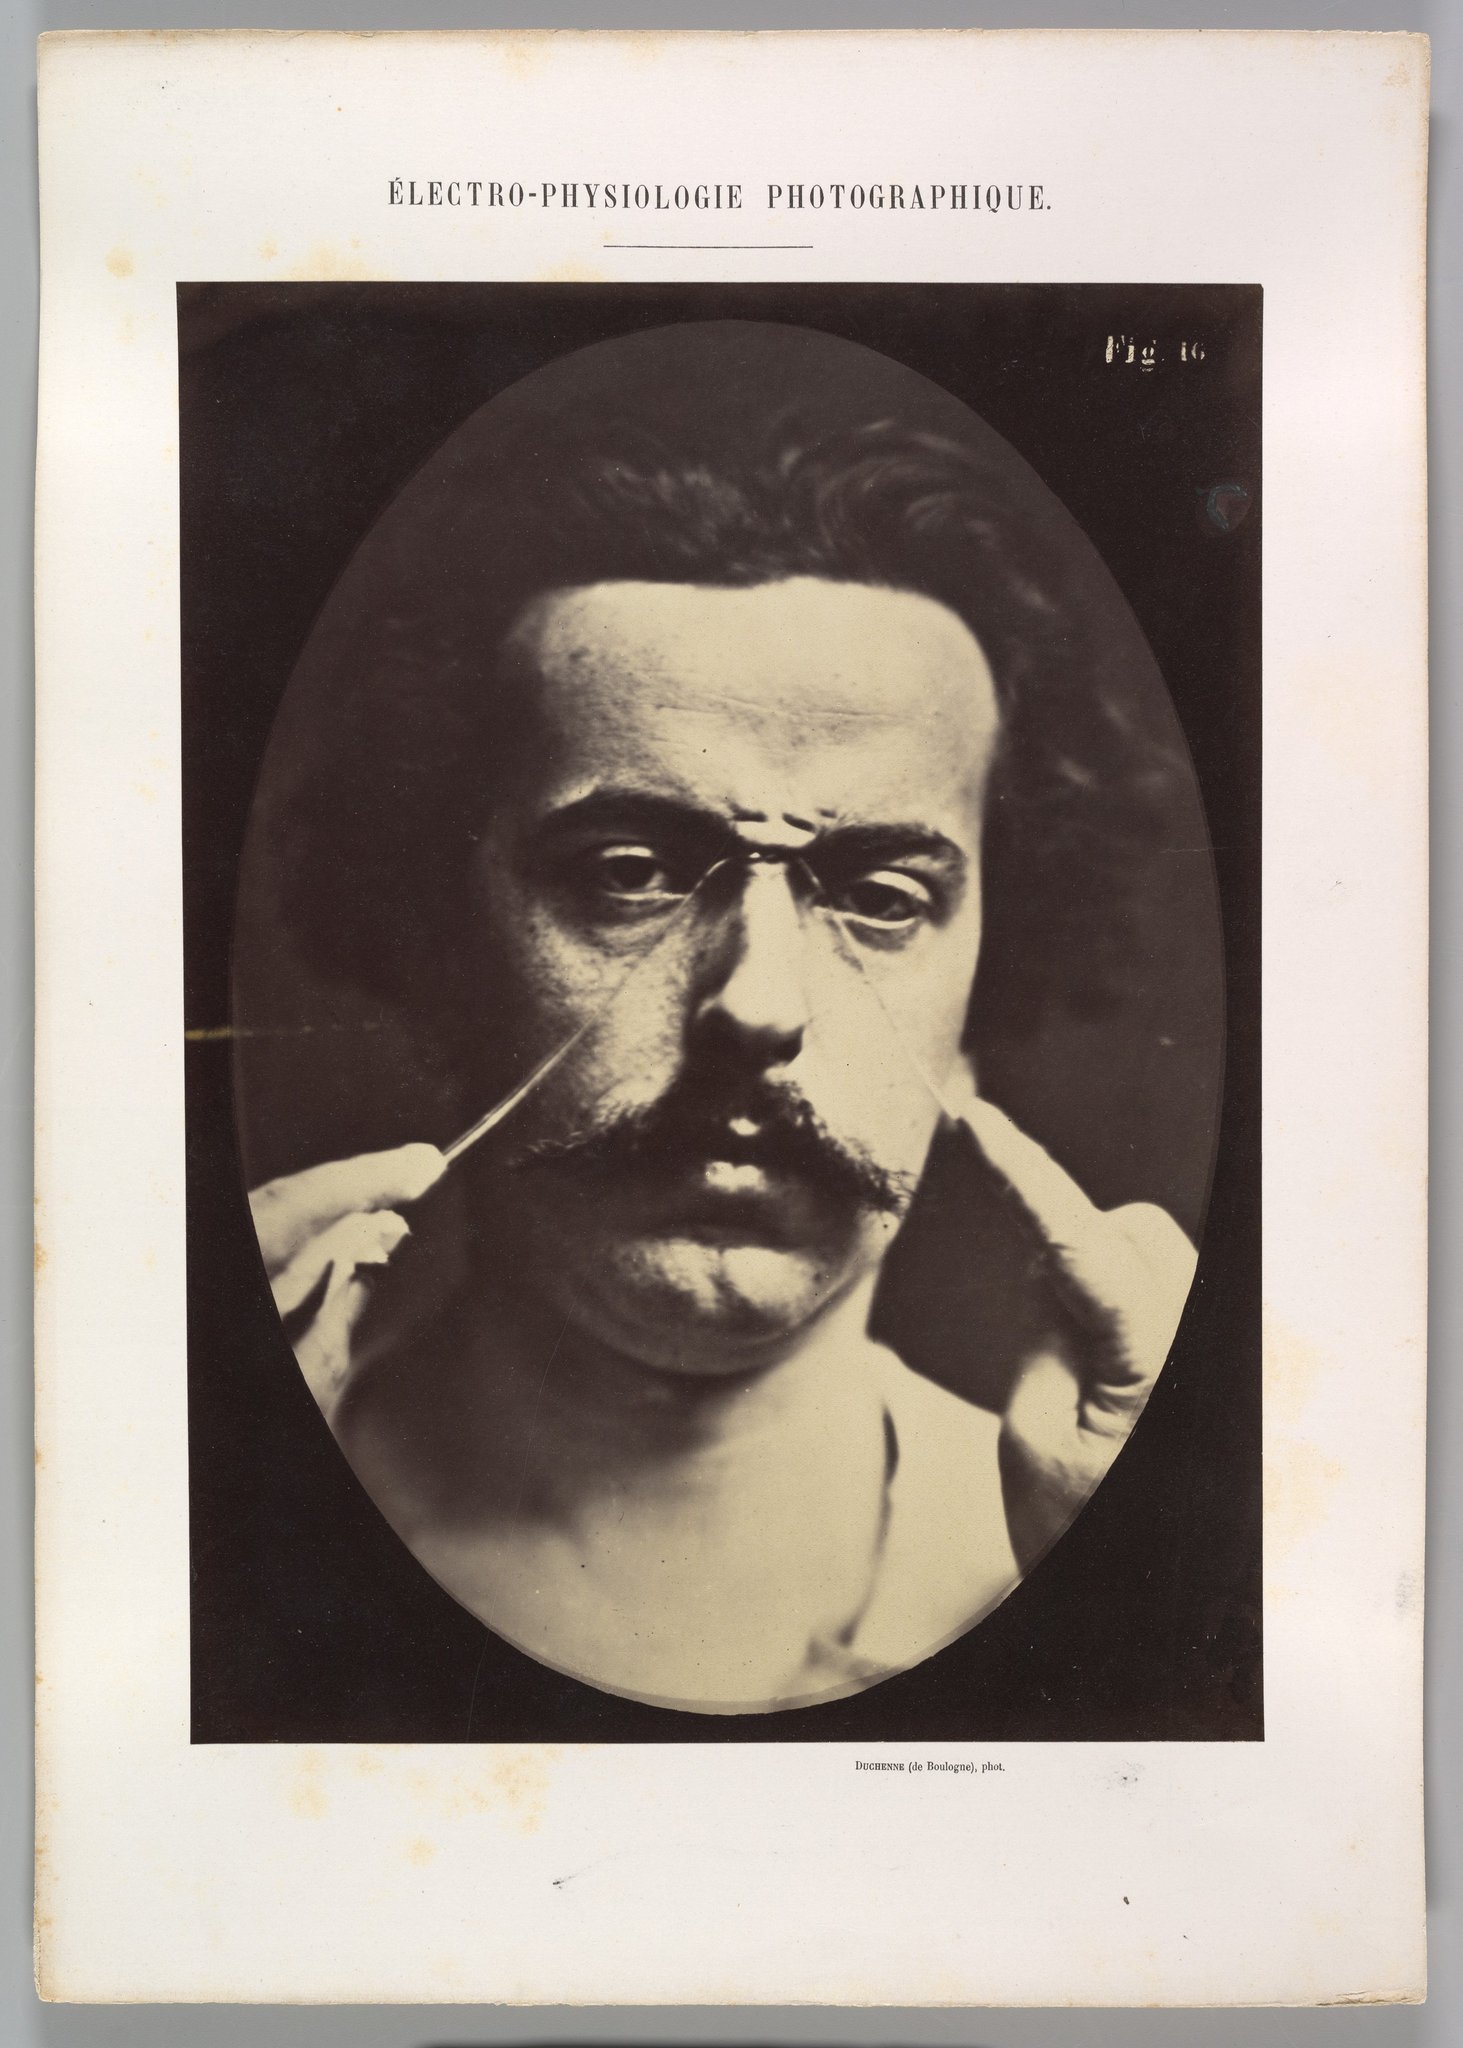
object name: photograph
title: Figure 16: Expression of severity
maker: guillaume-benjamin-amand duchenne de boulogne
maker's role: artist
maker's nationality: french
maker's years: 1806-1875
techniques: albumen silver print, glass negative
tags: science,men,portraits